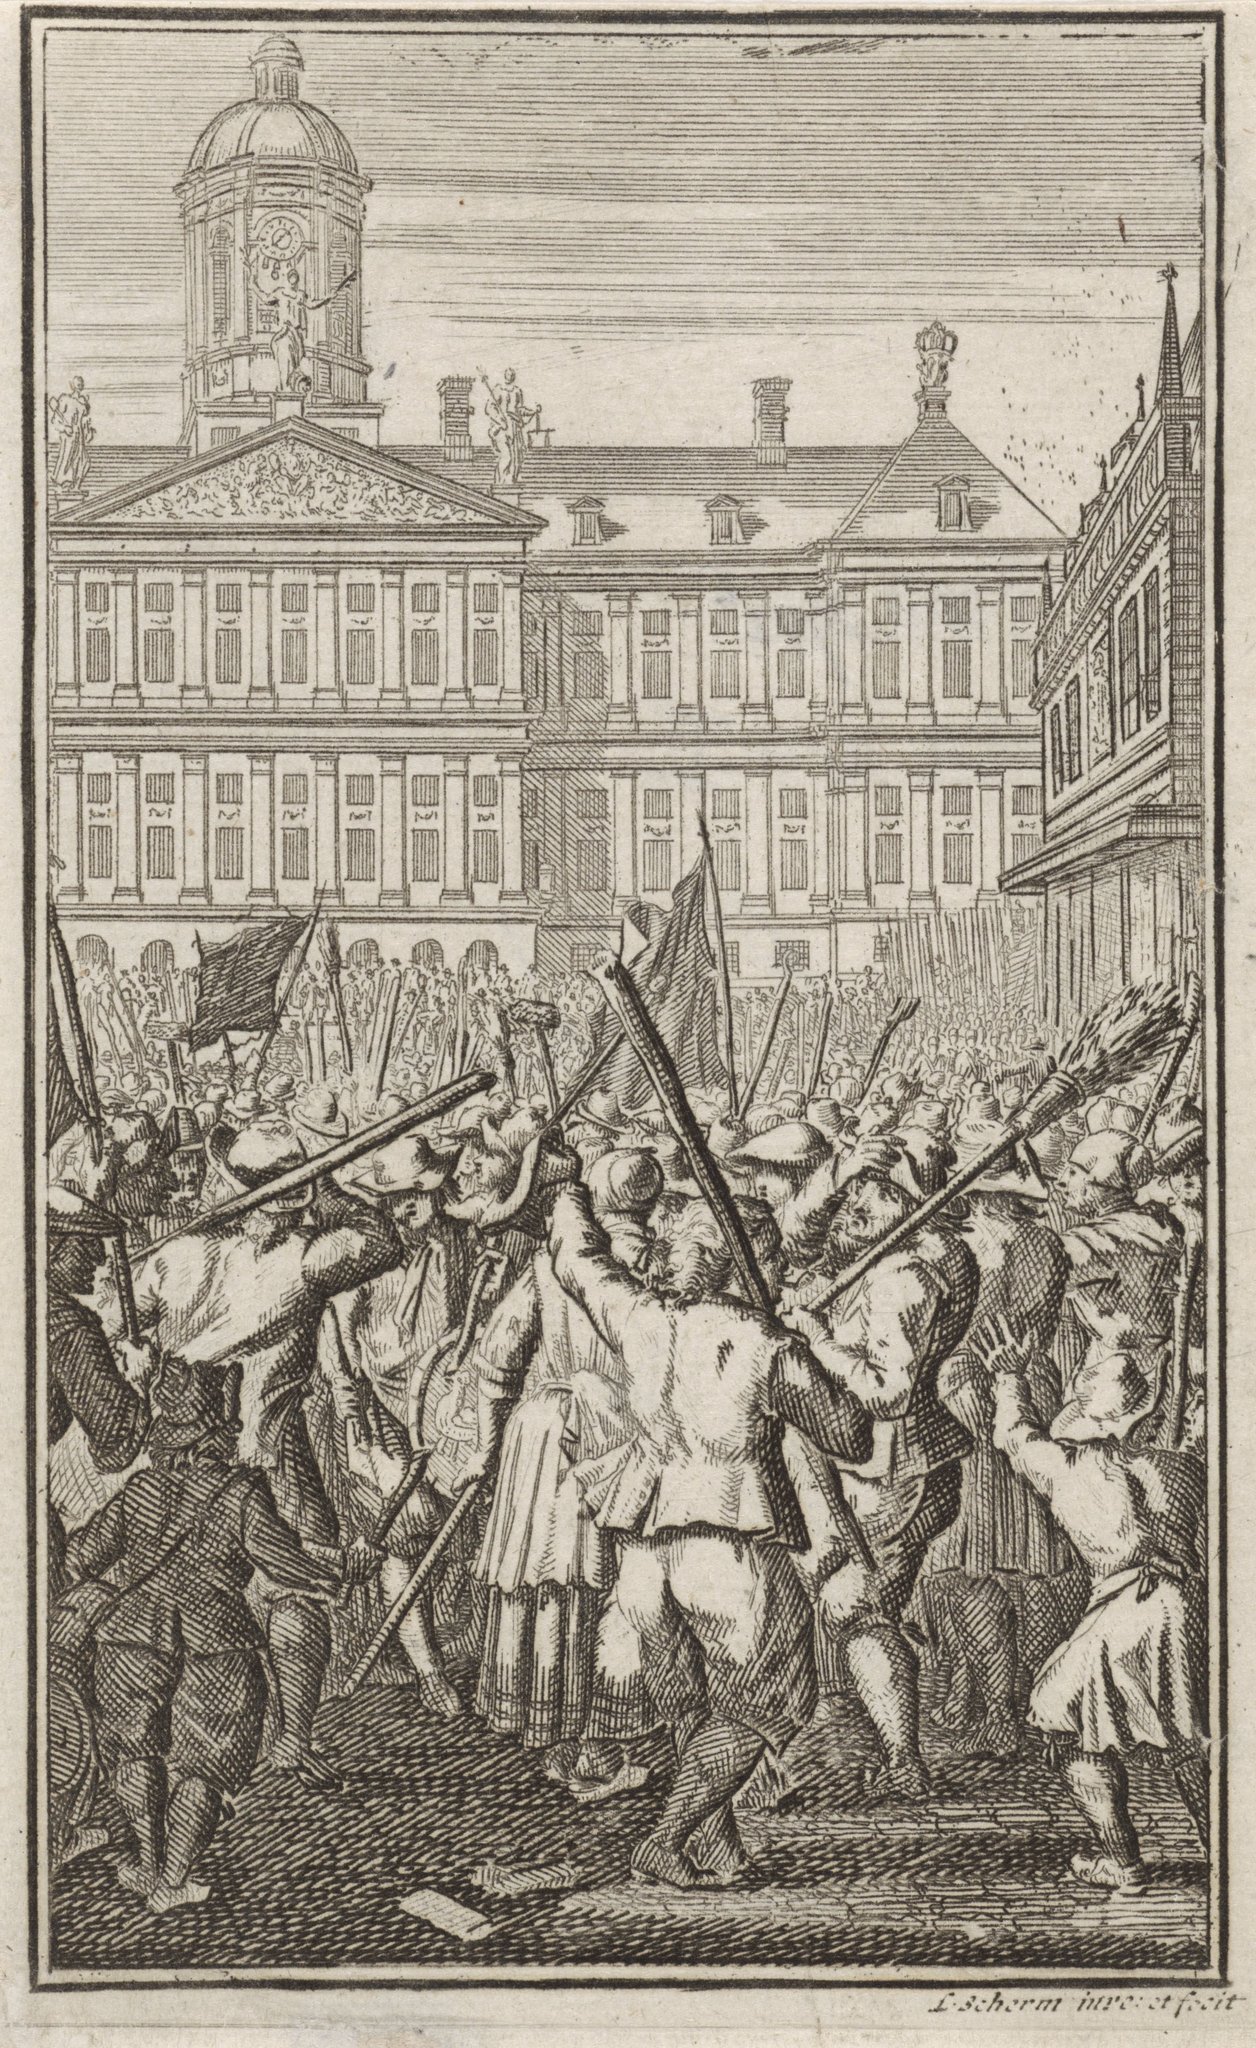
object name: print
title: Oproer op de Dam tijdens het Aansprekersoproer, 1696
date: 1702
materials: paper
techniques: engraving, etching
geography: amsterdam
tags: political demonstration, townhall, street-fights, riots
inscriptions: collector's mark: Lugt 2228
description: Huidige staat van prent ook gebruikt in: Rabus, Pieter. Historie van den oproer, te Amsterdam voorgevallen (…) 1696 (…). Amsterdam: Samuel Lamsveld, 1725. En in: Rabus, Pieter. Historie van den oproer, te Amsterdam voorgevallen (…) 1696 (…). Amsterdam: Samuel Lamsveld, 1733. Eerdere staat van prent (RP-P-AO-28-51-1) ook gebruikt in: Rabus, Pieter. Historie van den oproer, te Amsterdam voorgevallen (…) 1696 (…). Amsterdam: Willem van Lamsveld, 1702.